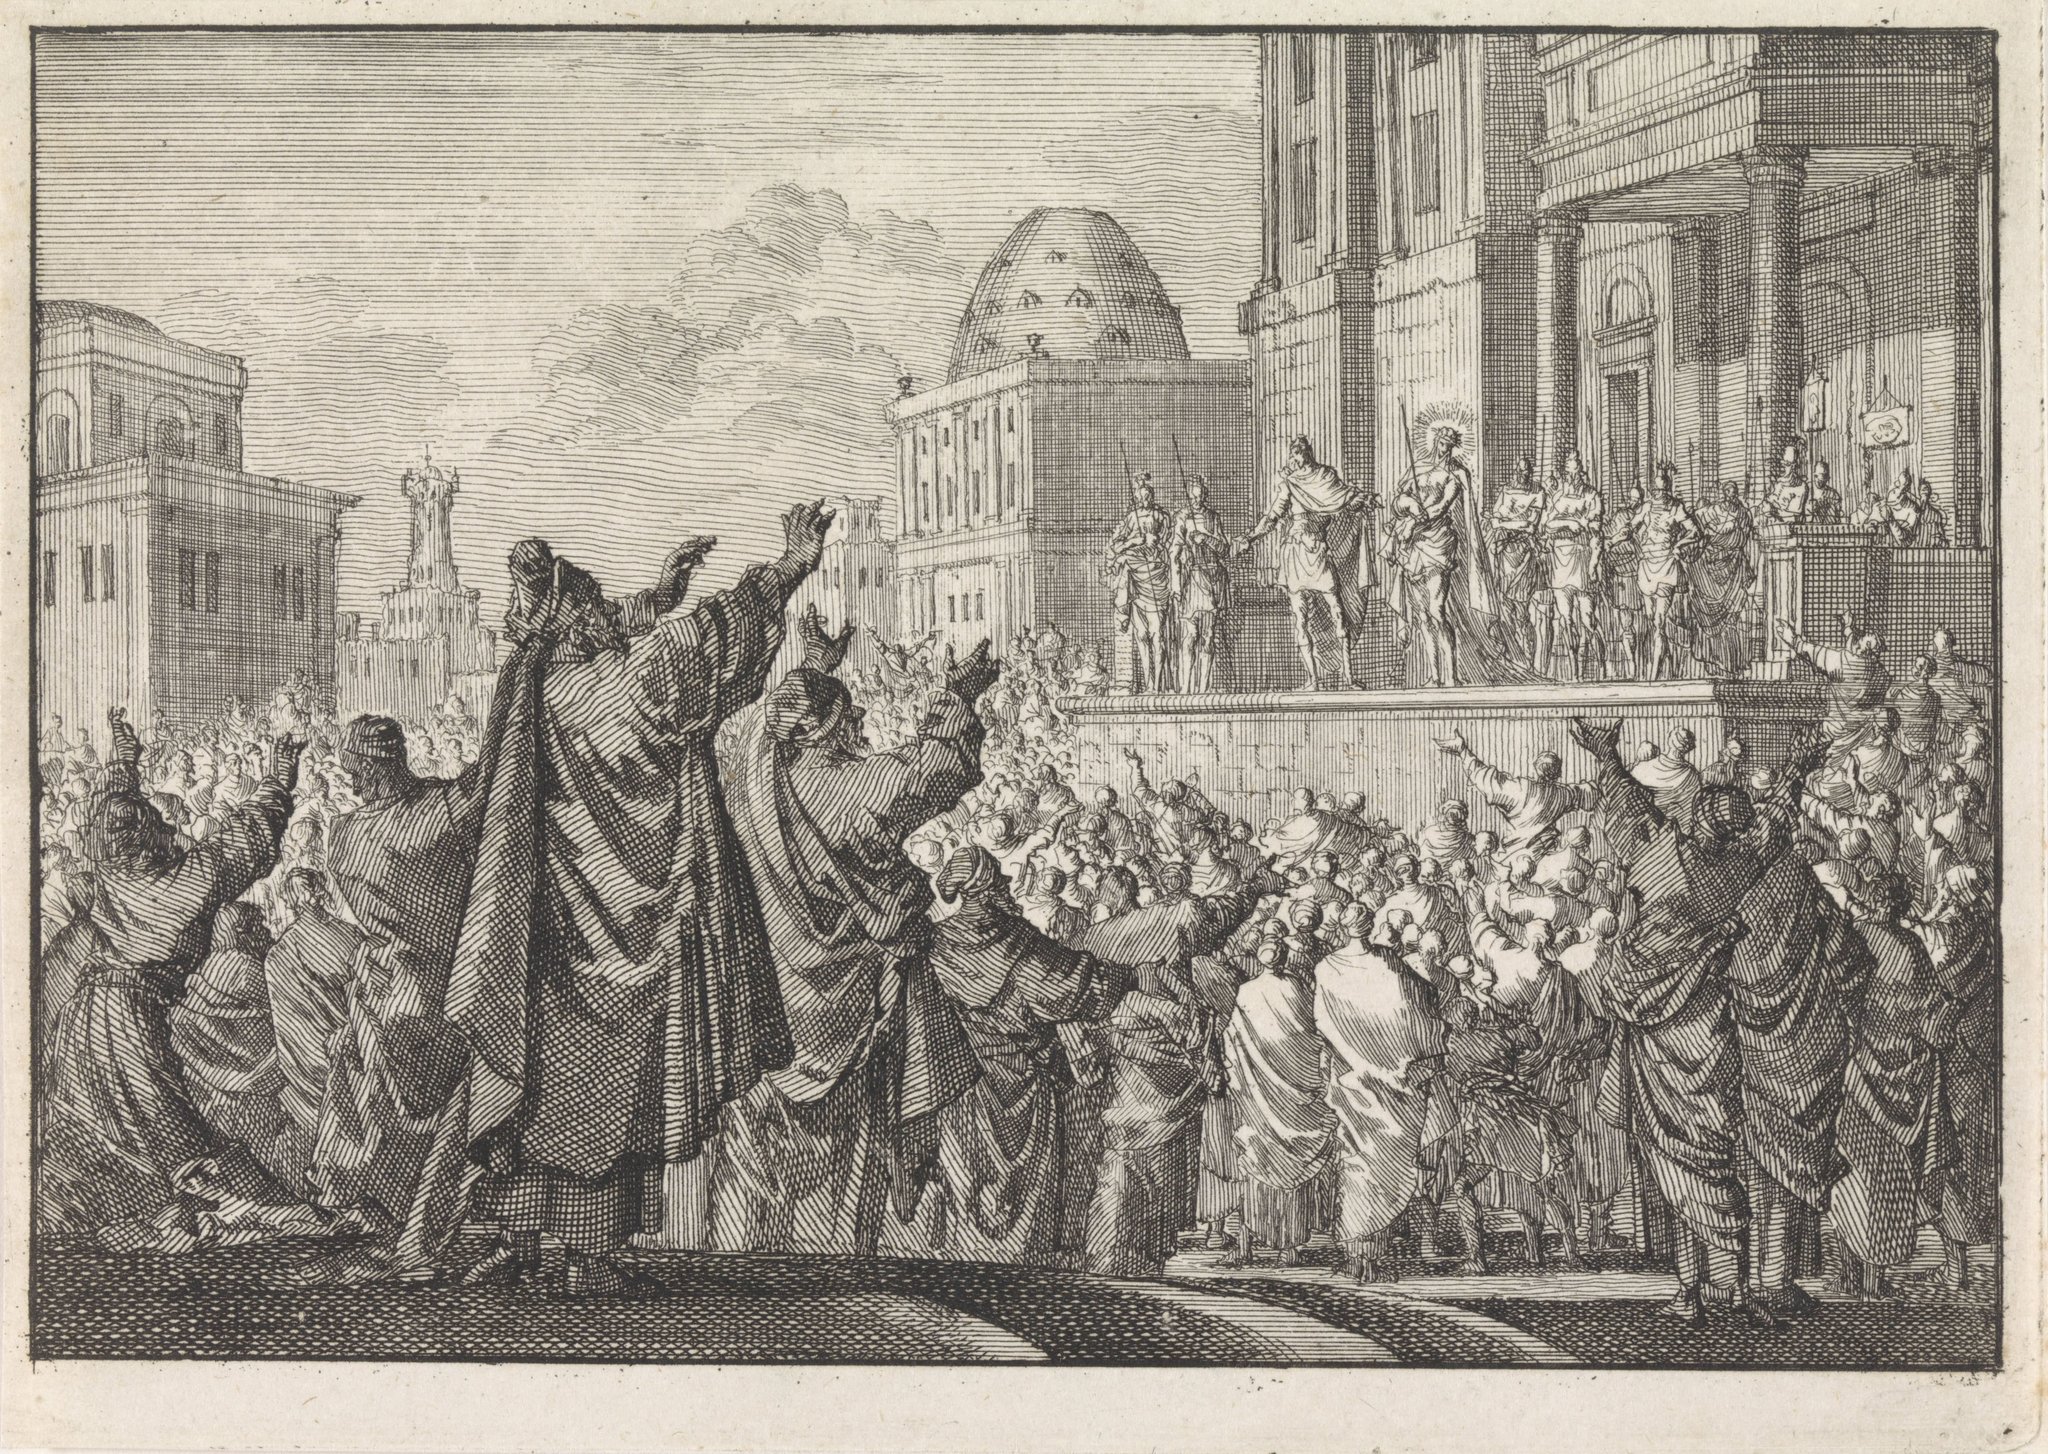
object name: print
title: Christus aan het volk getoond (Ecce Homo)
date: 1703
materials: paper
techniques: etching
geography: amsterdam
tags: pilate showing christ to the people, 'ostentatio christi', 'ecce homo' (john 19:4-6)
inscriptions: collector's mark: Lugt 2228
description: Proefdruk van een boekillustratie voor David Martin. Historie des Ouden en Nieuwen Testaments. Amsterdam, Pieter Mortier, 1703. Deel II. De boekillustraties voor de Mortierbijbel hebben verschillende staten en kopieën, waarbij de chronologische volgorde moeilijk te achterhalen valt. Als boekillustraties werden ze bovendien herhaaldelijk opnieuw gebruikt voor andere boekwerken.